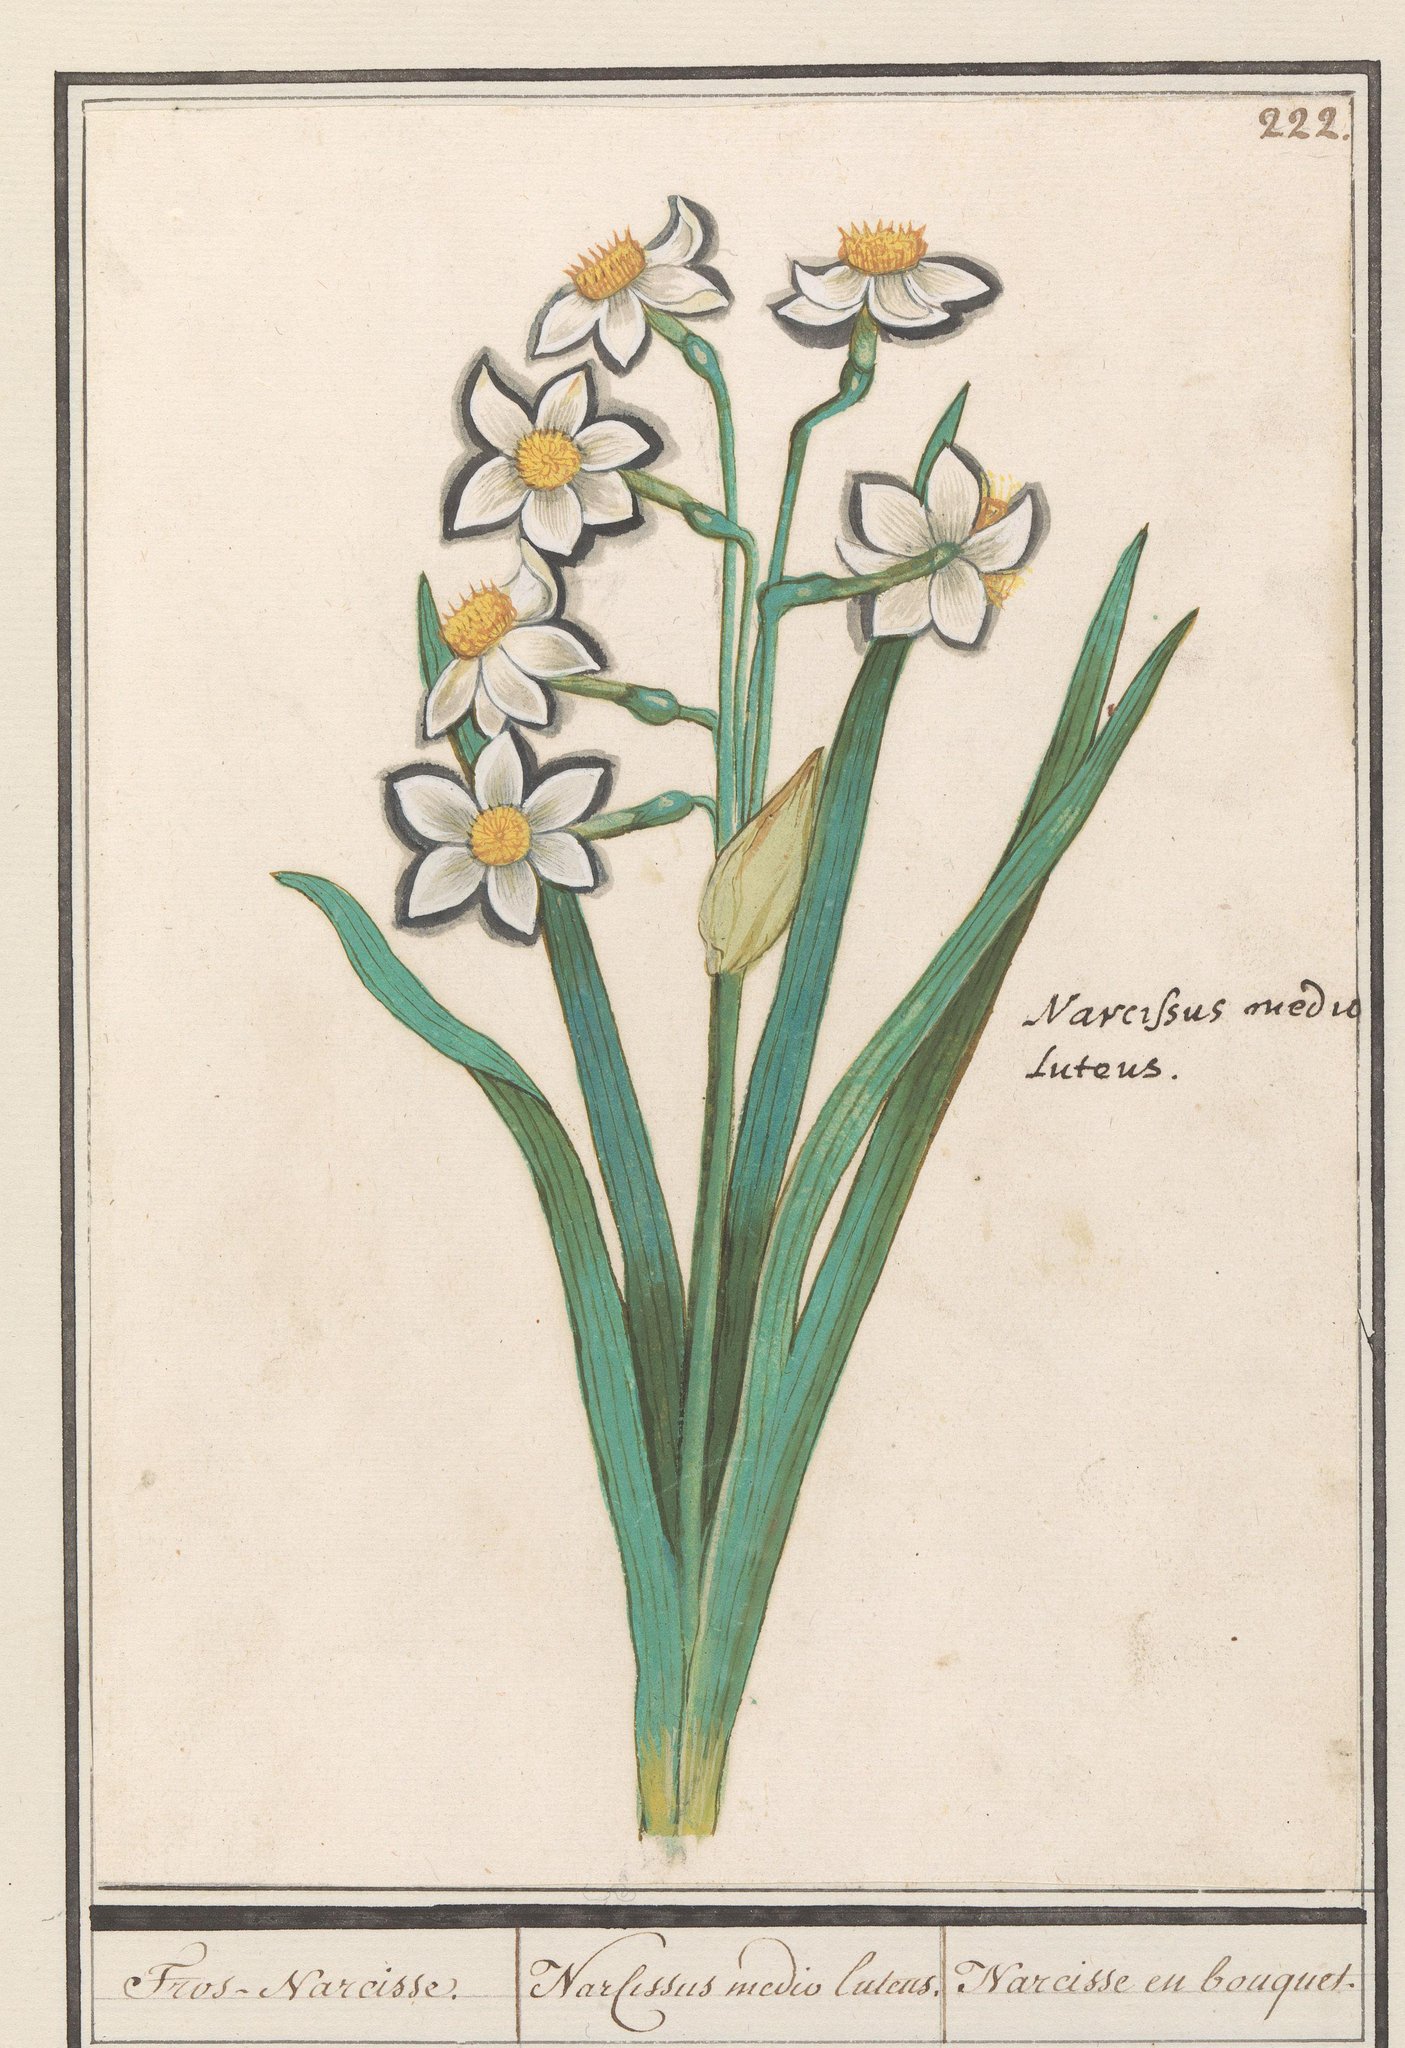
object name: drawing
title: Tros-narcisse. / Narcissus medio lutens. / Narcisse en bouquet.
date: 1596-1610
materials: chalk, paint, ink, paper, watercolor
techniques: brush, pen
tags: flowers: narcissus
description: Trosnarcis. Genummerd rechtsboven: 222. Rechts de Latijnse naam. Onderdeel van het derde album met tekeningen van bloemen en planten. Tiende van twaalf albums met tekeningen van dieren, vogels en planten bekend rond 1600, gemaakt in opdracht van keizer Rudolf II. Met toelichting in Nederlands, Latijn en Frans.